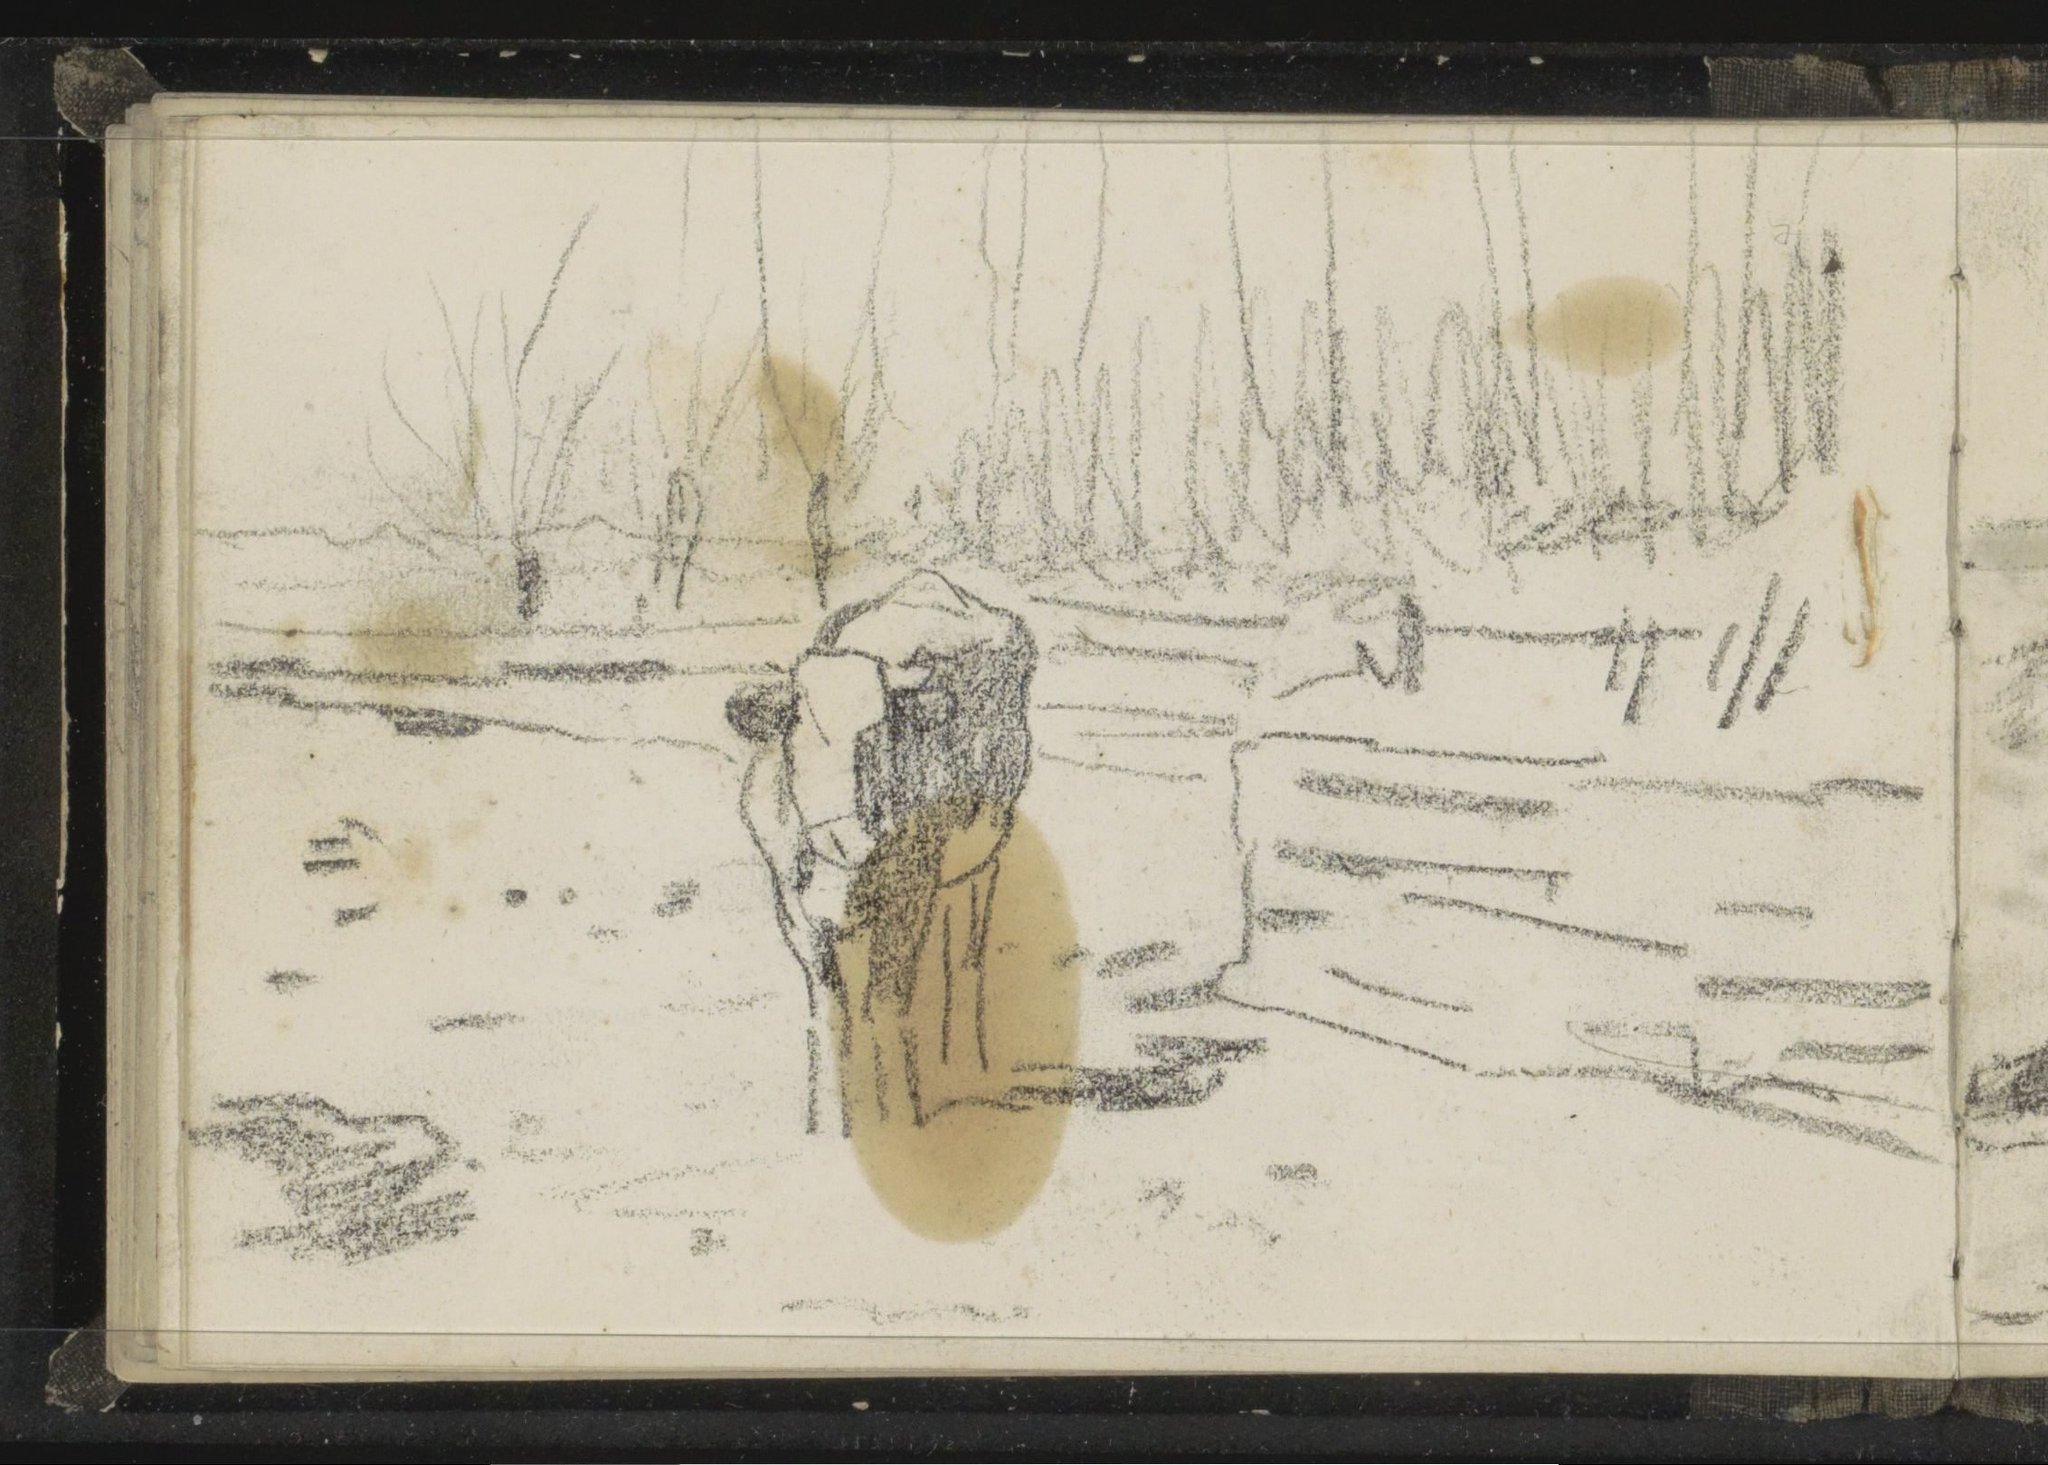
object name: sketchbook leaf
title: Koe in een weiland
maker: anton mauve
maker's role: draughtsman, painter, print maker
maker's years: 1838-1888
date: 1848-1888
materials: chalk, paper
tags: cow, meadow, pasture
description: Op de achtergrond een rij knotwilgen. Blad 30 verso uit een schetsboek met 33 bladen.